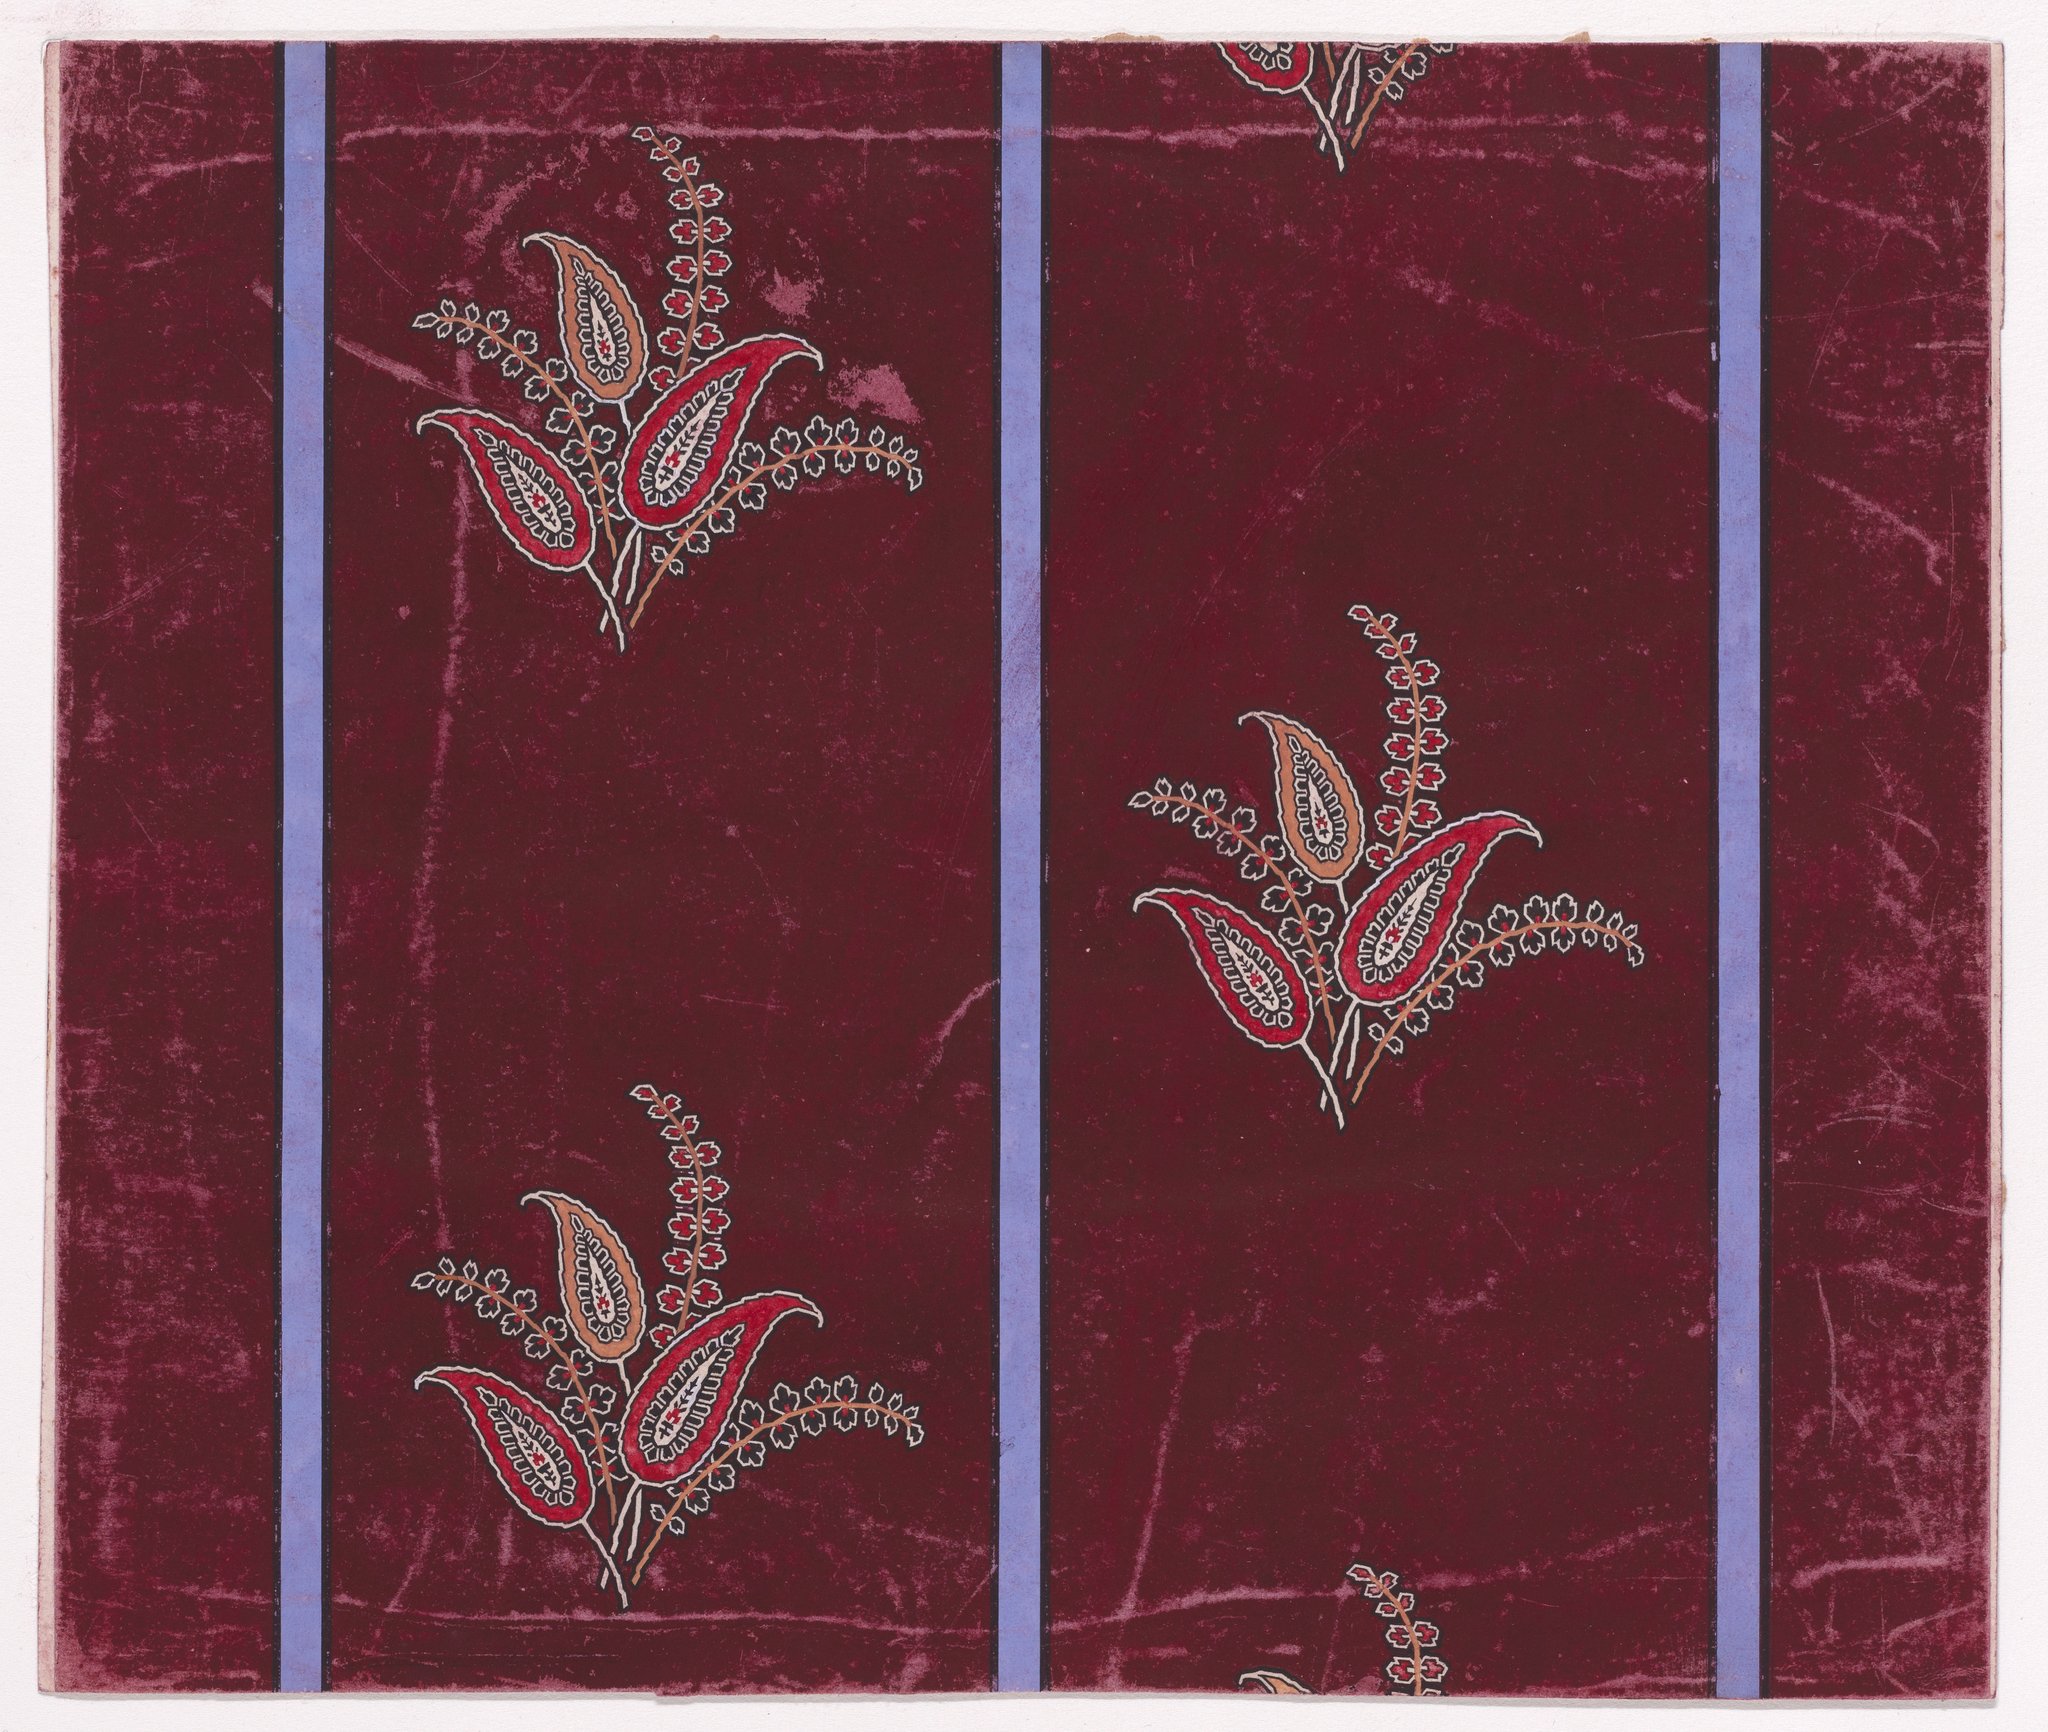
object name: drawing ornament architecture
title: Textile Design with Alternating Vertical Rows of Bunches of Large Paisley-Inspired Stylized Leaves and Branches with Pairs of Stylized Leaves Separated by Vertical Stripes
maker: anonymous, alsatian, 19th century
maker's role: artist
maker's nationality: alsatian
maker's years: 1800-1900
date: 1840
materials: gouache